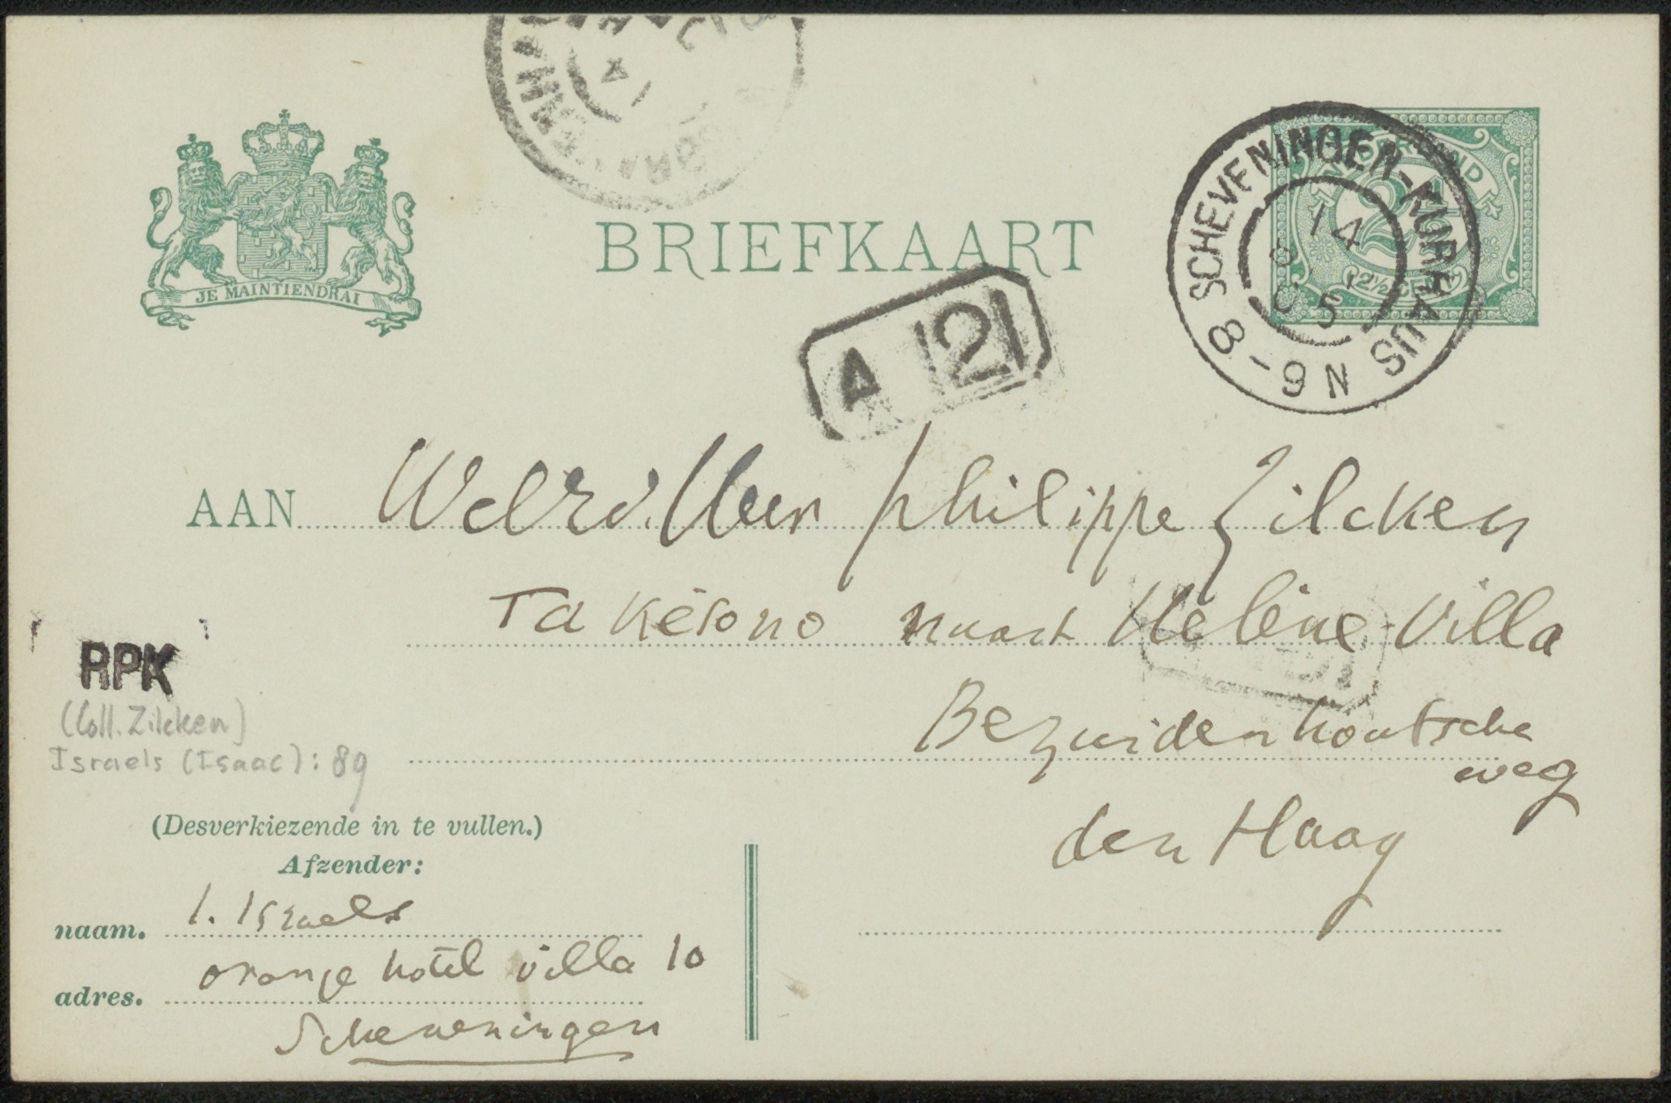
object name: postcard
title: Briefkaart aan Philip Zilcken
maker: isaac israels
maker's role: draughtsman, painter, print maker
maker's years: 1865-1934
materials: cardboard, ink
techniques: writing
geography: scheveningen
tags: philip zilcken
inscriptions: collector's mark: ‘RPK’